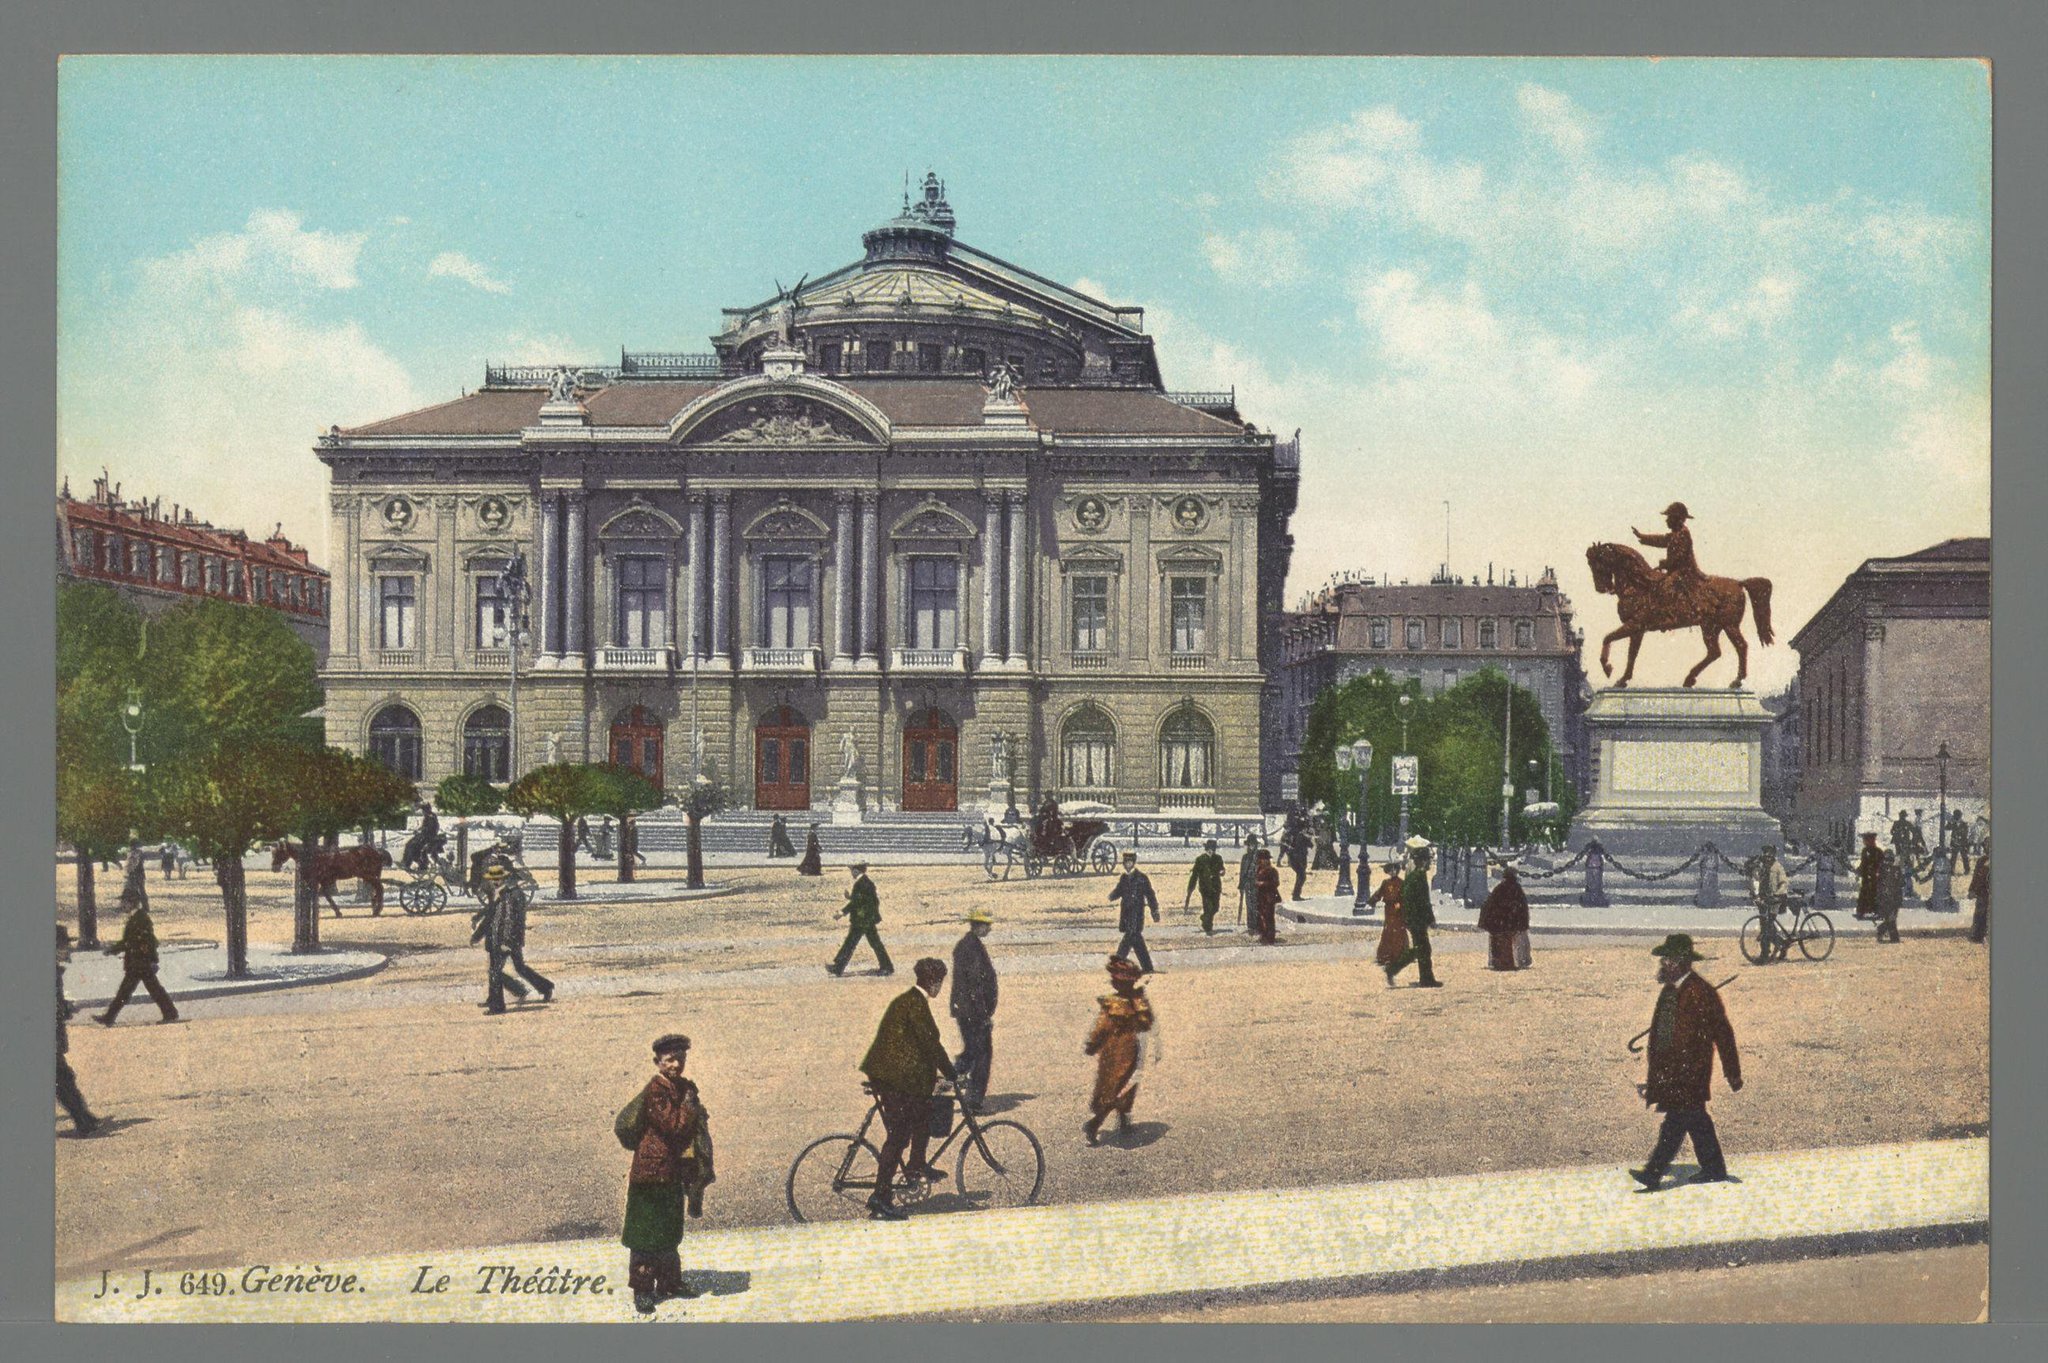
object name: ansichtkaart, prentbriefkaart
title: Genève. Le Théâtre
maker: Anonymous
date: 1905-1918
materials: cardboard, photographic process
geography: geneva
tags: buildings for performances, square, place, circus, etc. (+ city(-scape) with figures, staffage)